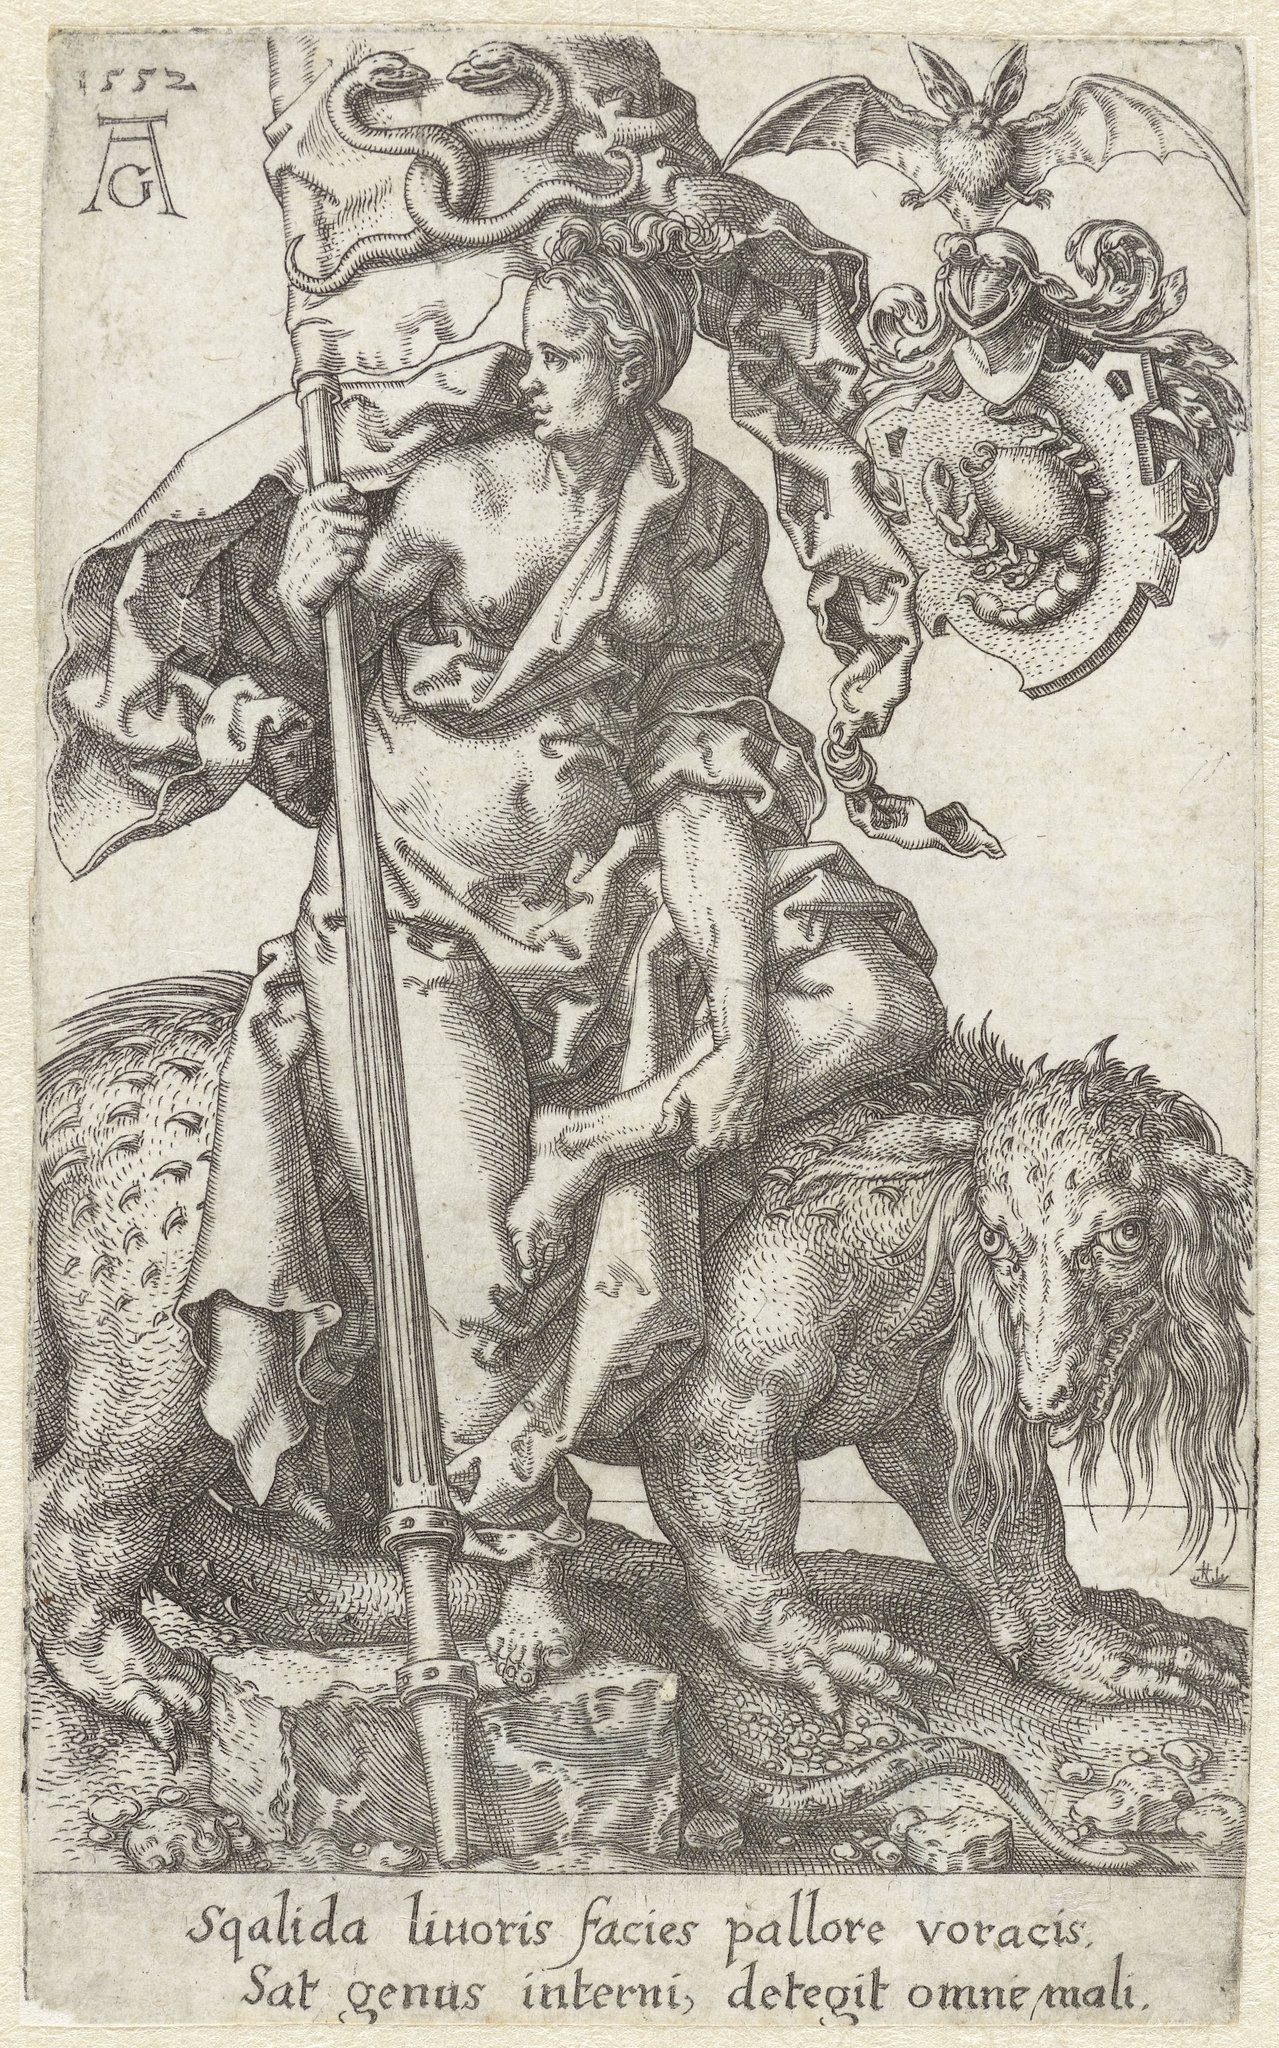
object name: print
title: Afgunst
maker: heinrich aldegrever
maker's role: draughtsman, print maker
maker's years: 1502-1561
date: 1552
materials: paper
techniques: engraving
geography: germany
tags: envy; 'invidia' (ripa) ~ personification of one of the seven deadly sins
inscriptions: collector's mark: Lugt 11, collector's mark: ‘Hinloopen’ Lugt 11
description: Personificatie van afgunst. Vrouw zittend op een monster, in haar rechterhand een vaandel met een afbeelding van twee slangen. Rechtsboven een wapenschild met een schorpioen, daarboven een vleermuis. Onder de voorstelling een tweeregelige tekst in het Latijn. Tweede prent uit een serie van zeven.